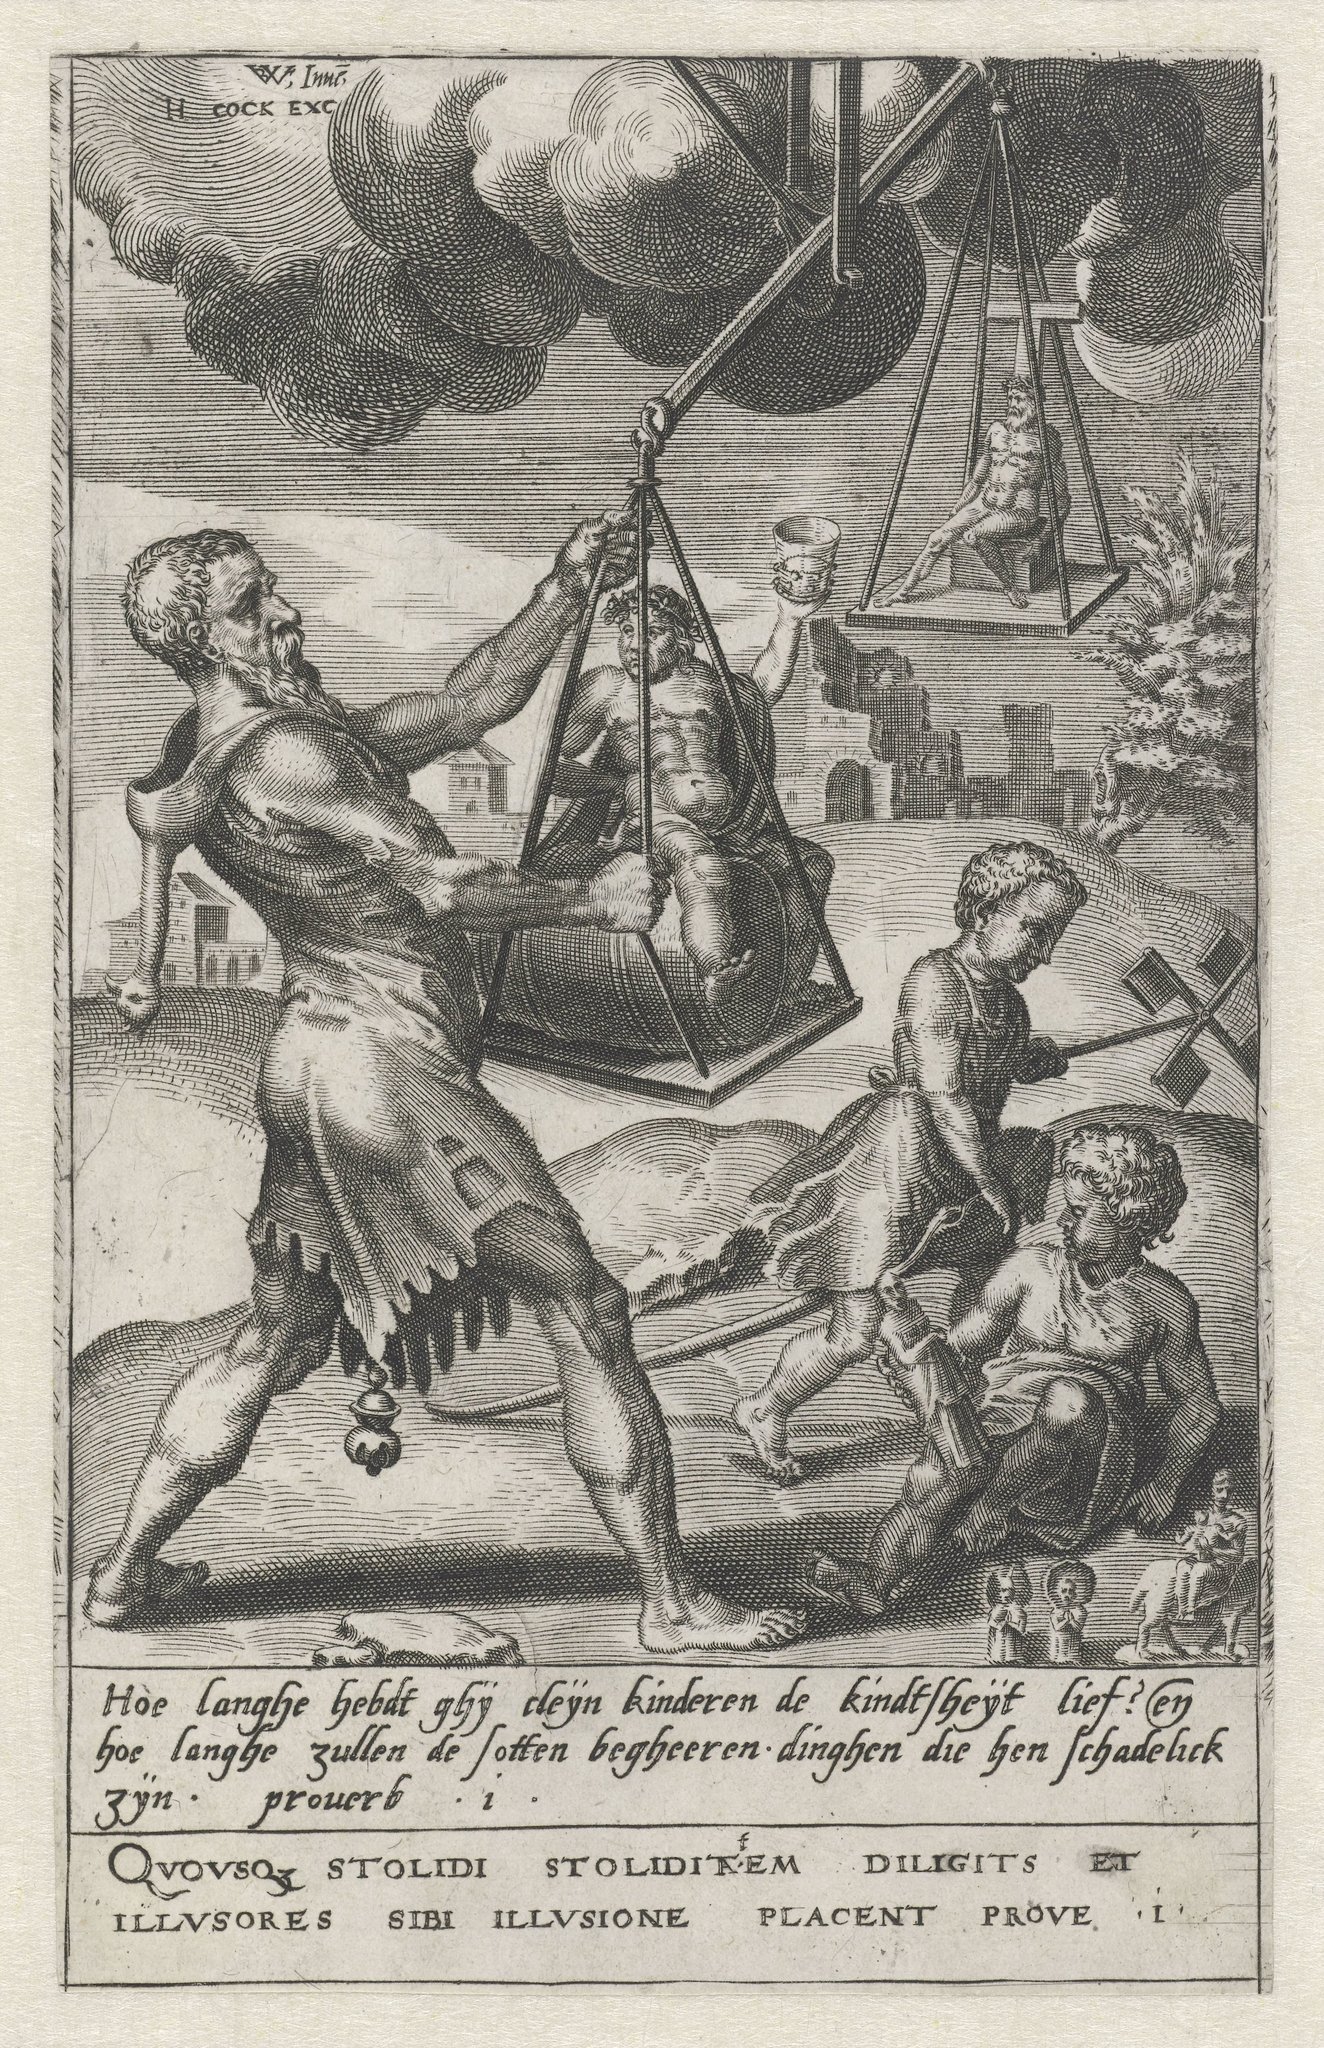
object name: print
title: Dwaasheid van het menselijke leven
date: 1556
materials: paper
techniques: engraving, etching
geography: haarlem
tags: children's games and plays, (story of) bacchus (dionysus), liber, fool, simpleton, numskull, christ in agony waiting to be crucified; he is sitting on or near the cross or on a stone, 'christus im elend', 'christus in der rast', scales, proverbs, sayings, etc.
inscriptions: collector's mark: Lugt 2228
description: Een zot trekt met beide handen aan een enorme weegschaal, die door de hemel wordt opgehouden. Hij kiest de kant van de weegschaal waar Bacchus op zit. De god van de wijn heft een wijnglas omhoog en zit op een wijnton. Christus, met doornenkroon en kruis, zit aan de andere kant van de weegschaal. Die laat de zot schieten. Naast hem twee kinderen. Een speelt met een stokpaard, de andere met poppen. De prent valt te interpreteren als een allusie op het leven van de mens. Hij zal na zijn kinderjaren moeten kiezen tussen vroomheid en aardse lusten. De prent heeft een Nederlands en Latijns onderschrift.